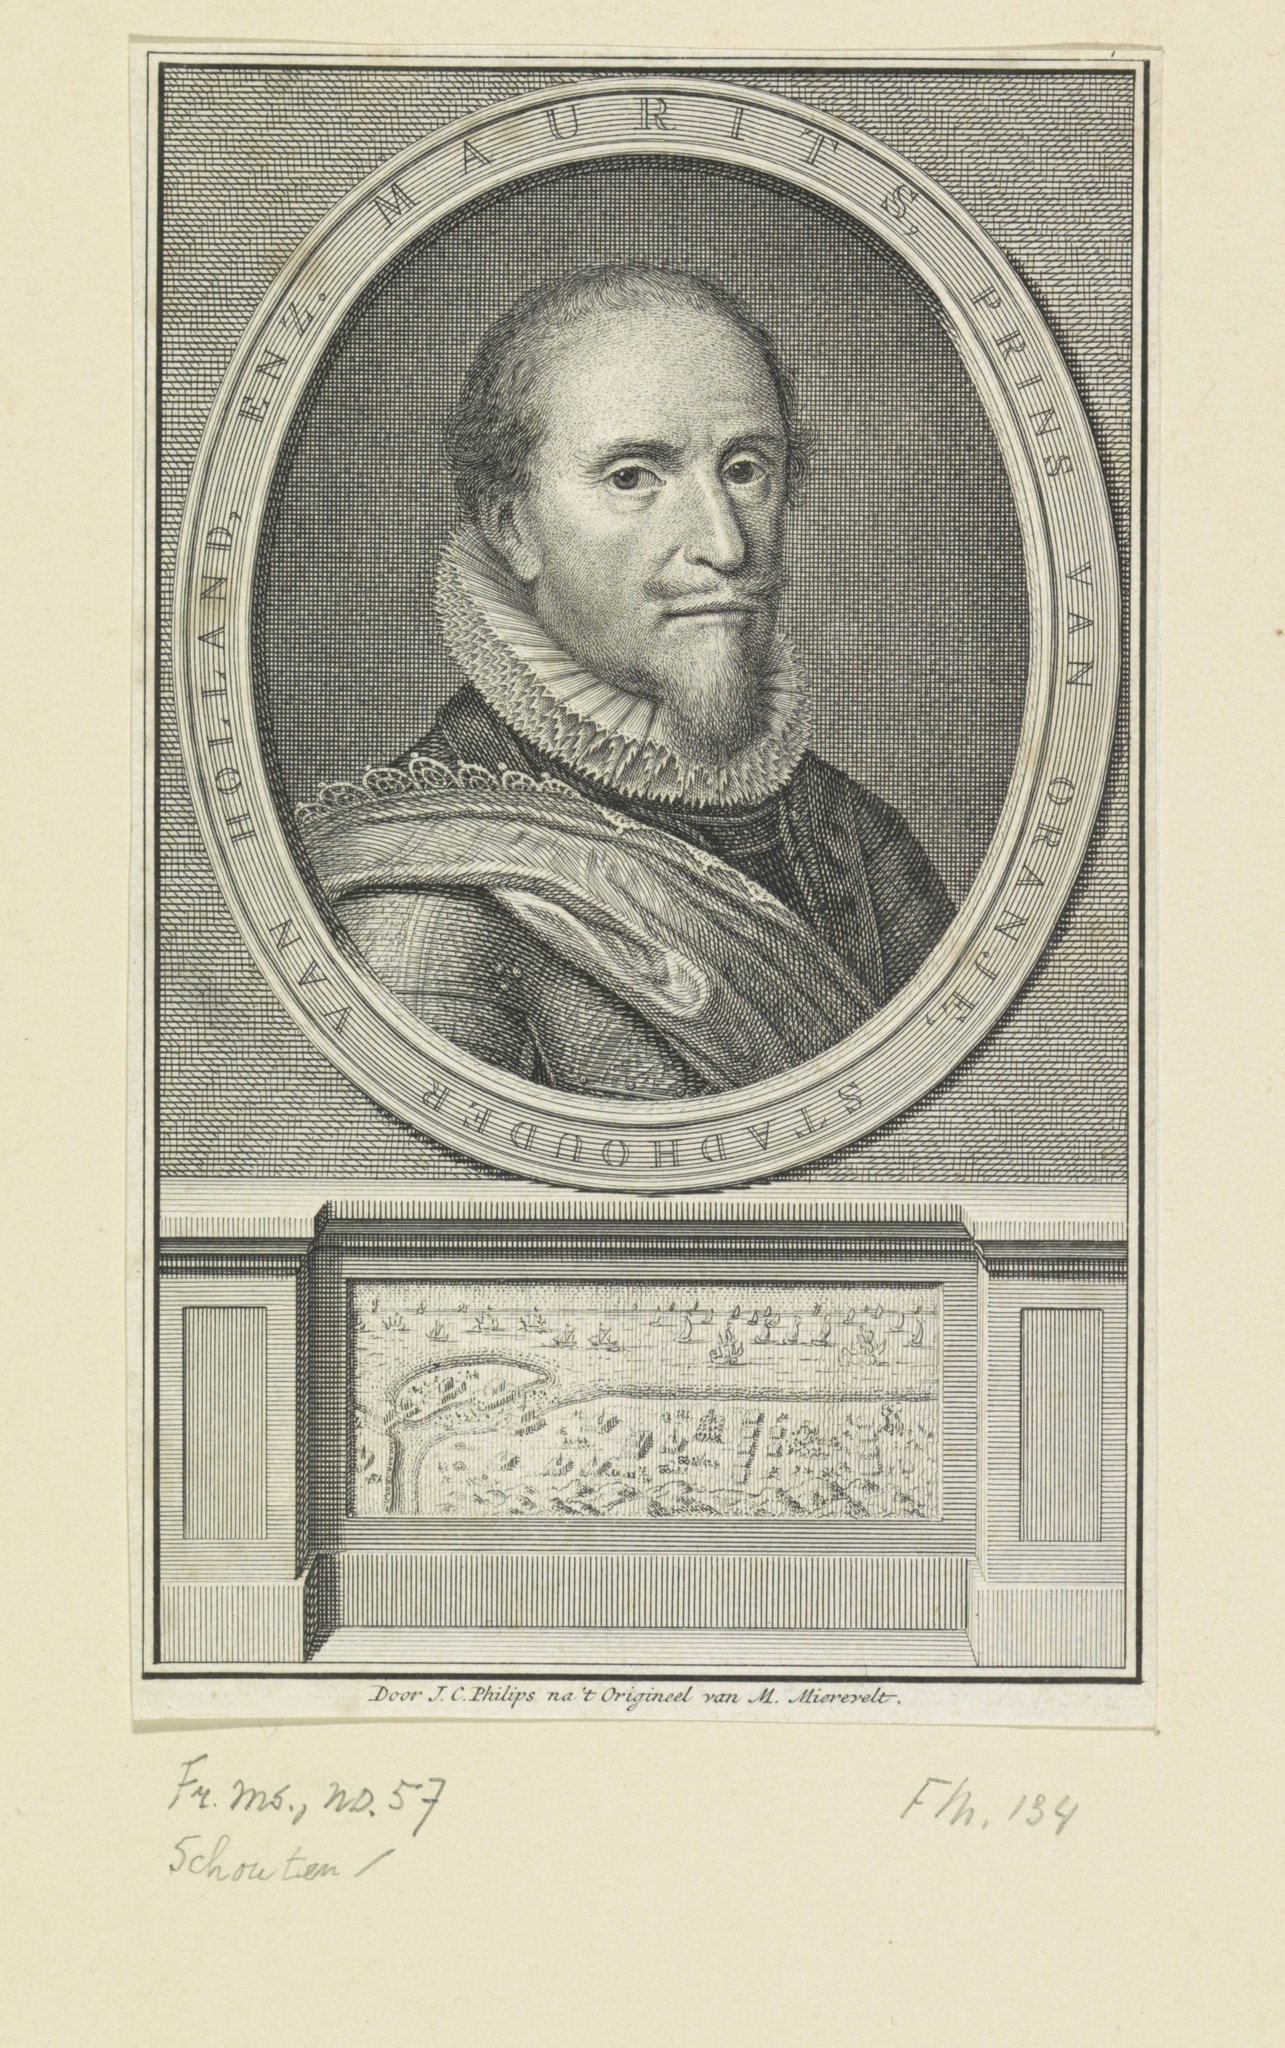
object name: print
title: Portret van Maurits, prins van Oranje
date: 1736-1775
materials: paper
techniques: engraving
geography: amsterdam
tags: the hague, maurice (prince of orange), battle of nieuwpoort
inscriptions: collector's mark: Lugt 963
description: De hier vermelde titel verwijst naar de hoogst verkregen titel van de geportretteerde, niet per se naar de titel die de geportretteerde op deze voorstelling draagt.